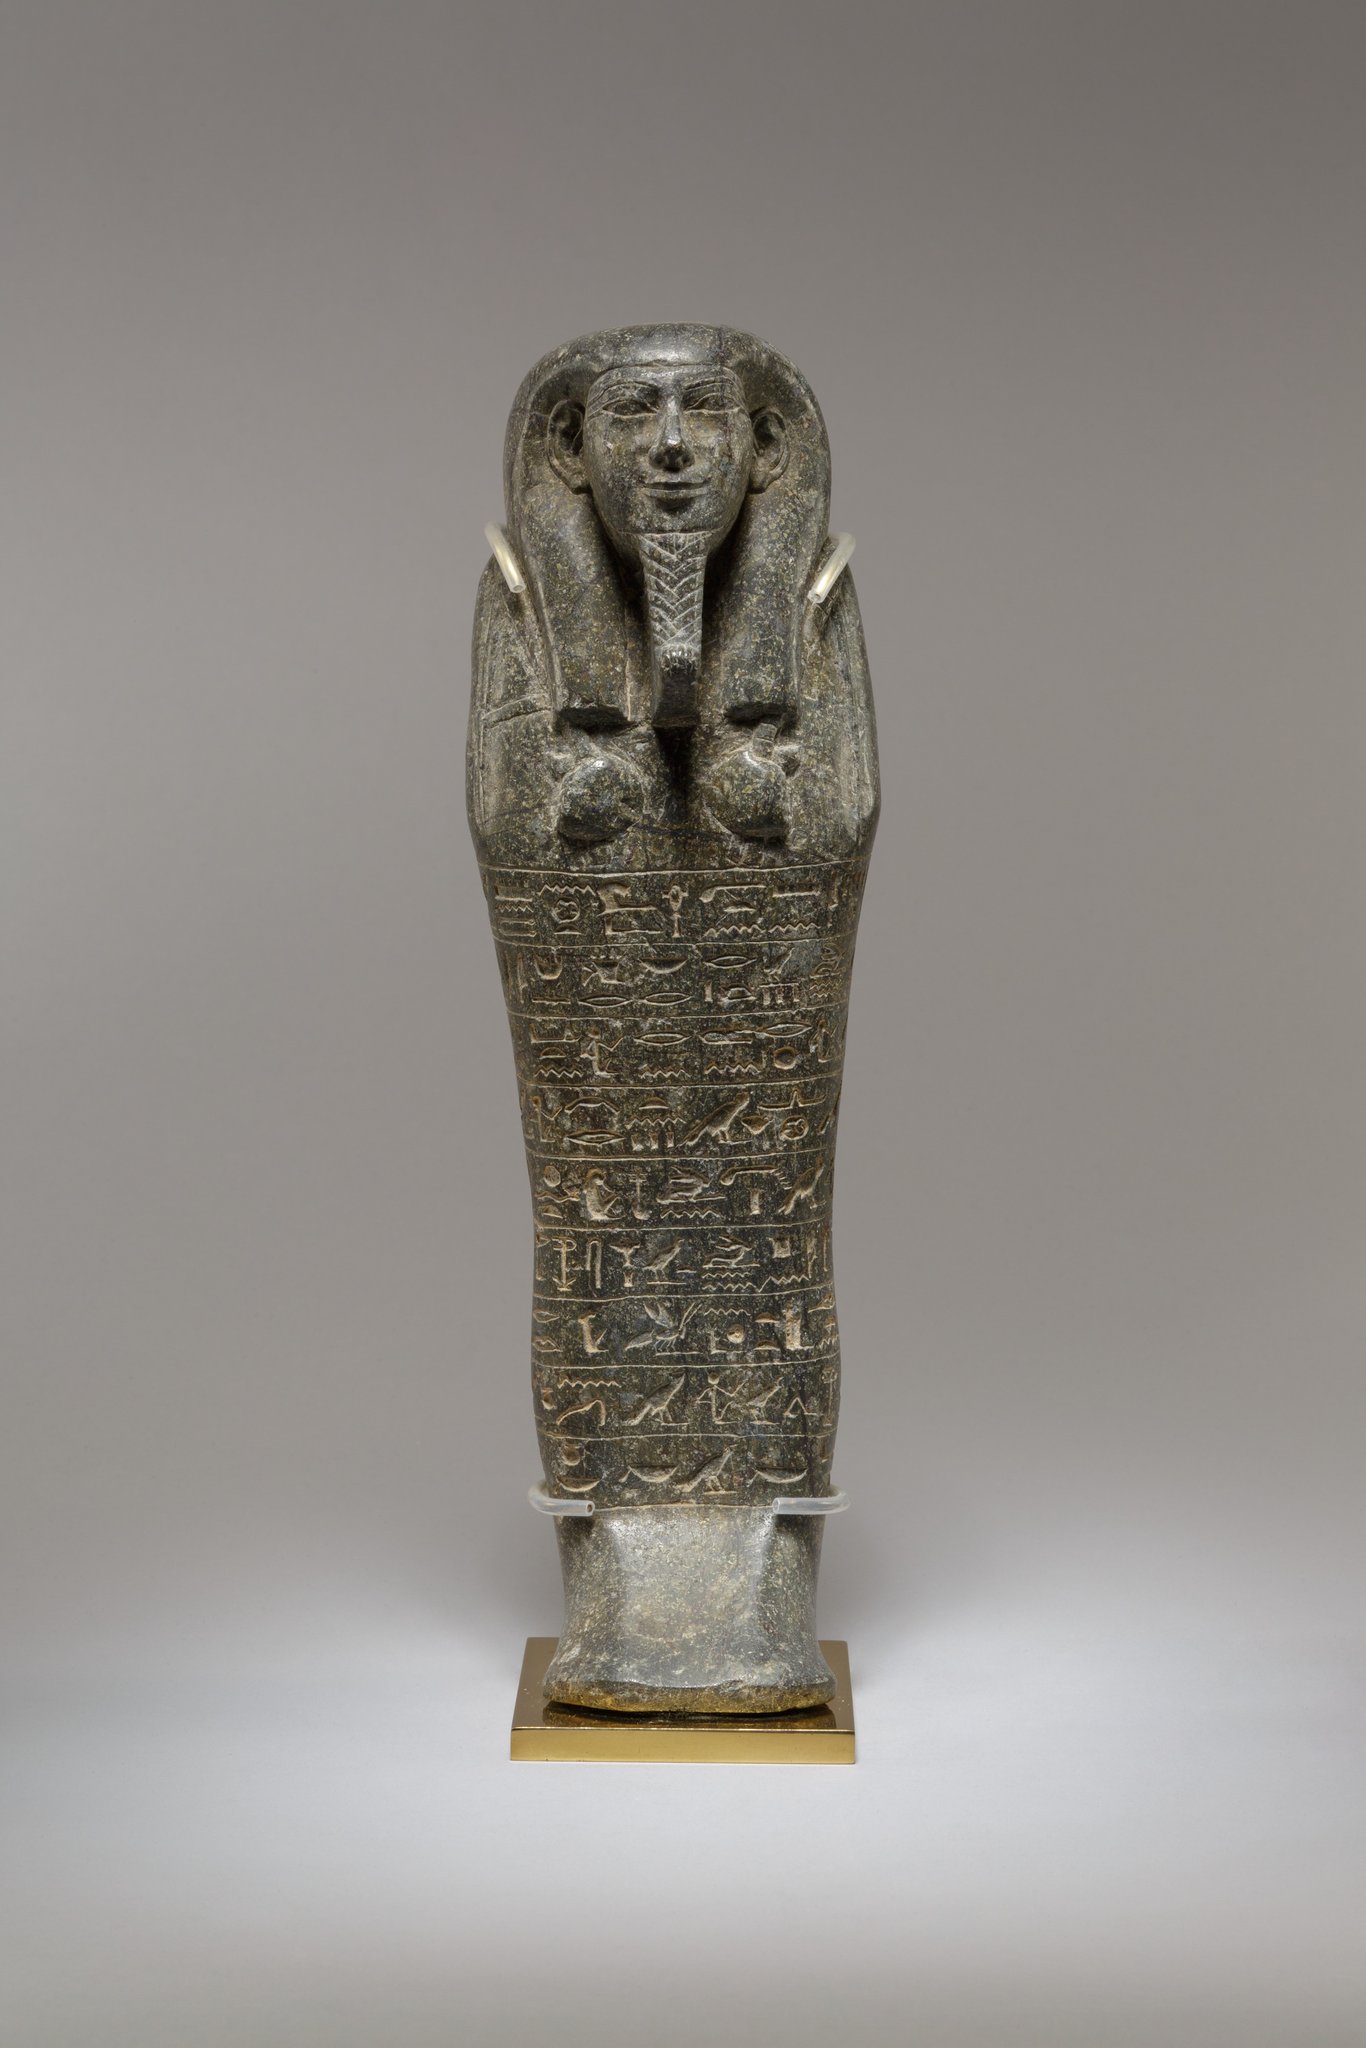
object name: shabti, mentuemhat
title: Shabti of Mentuemhat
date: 690-645 BCE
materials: stone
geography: egypt